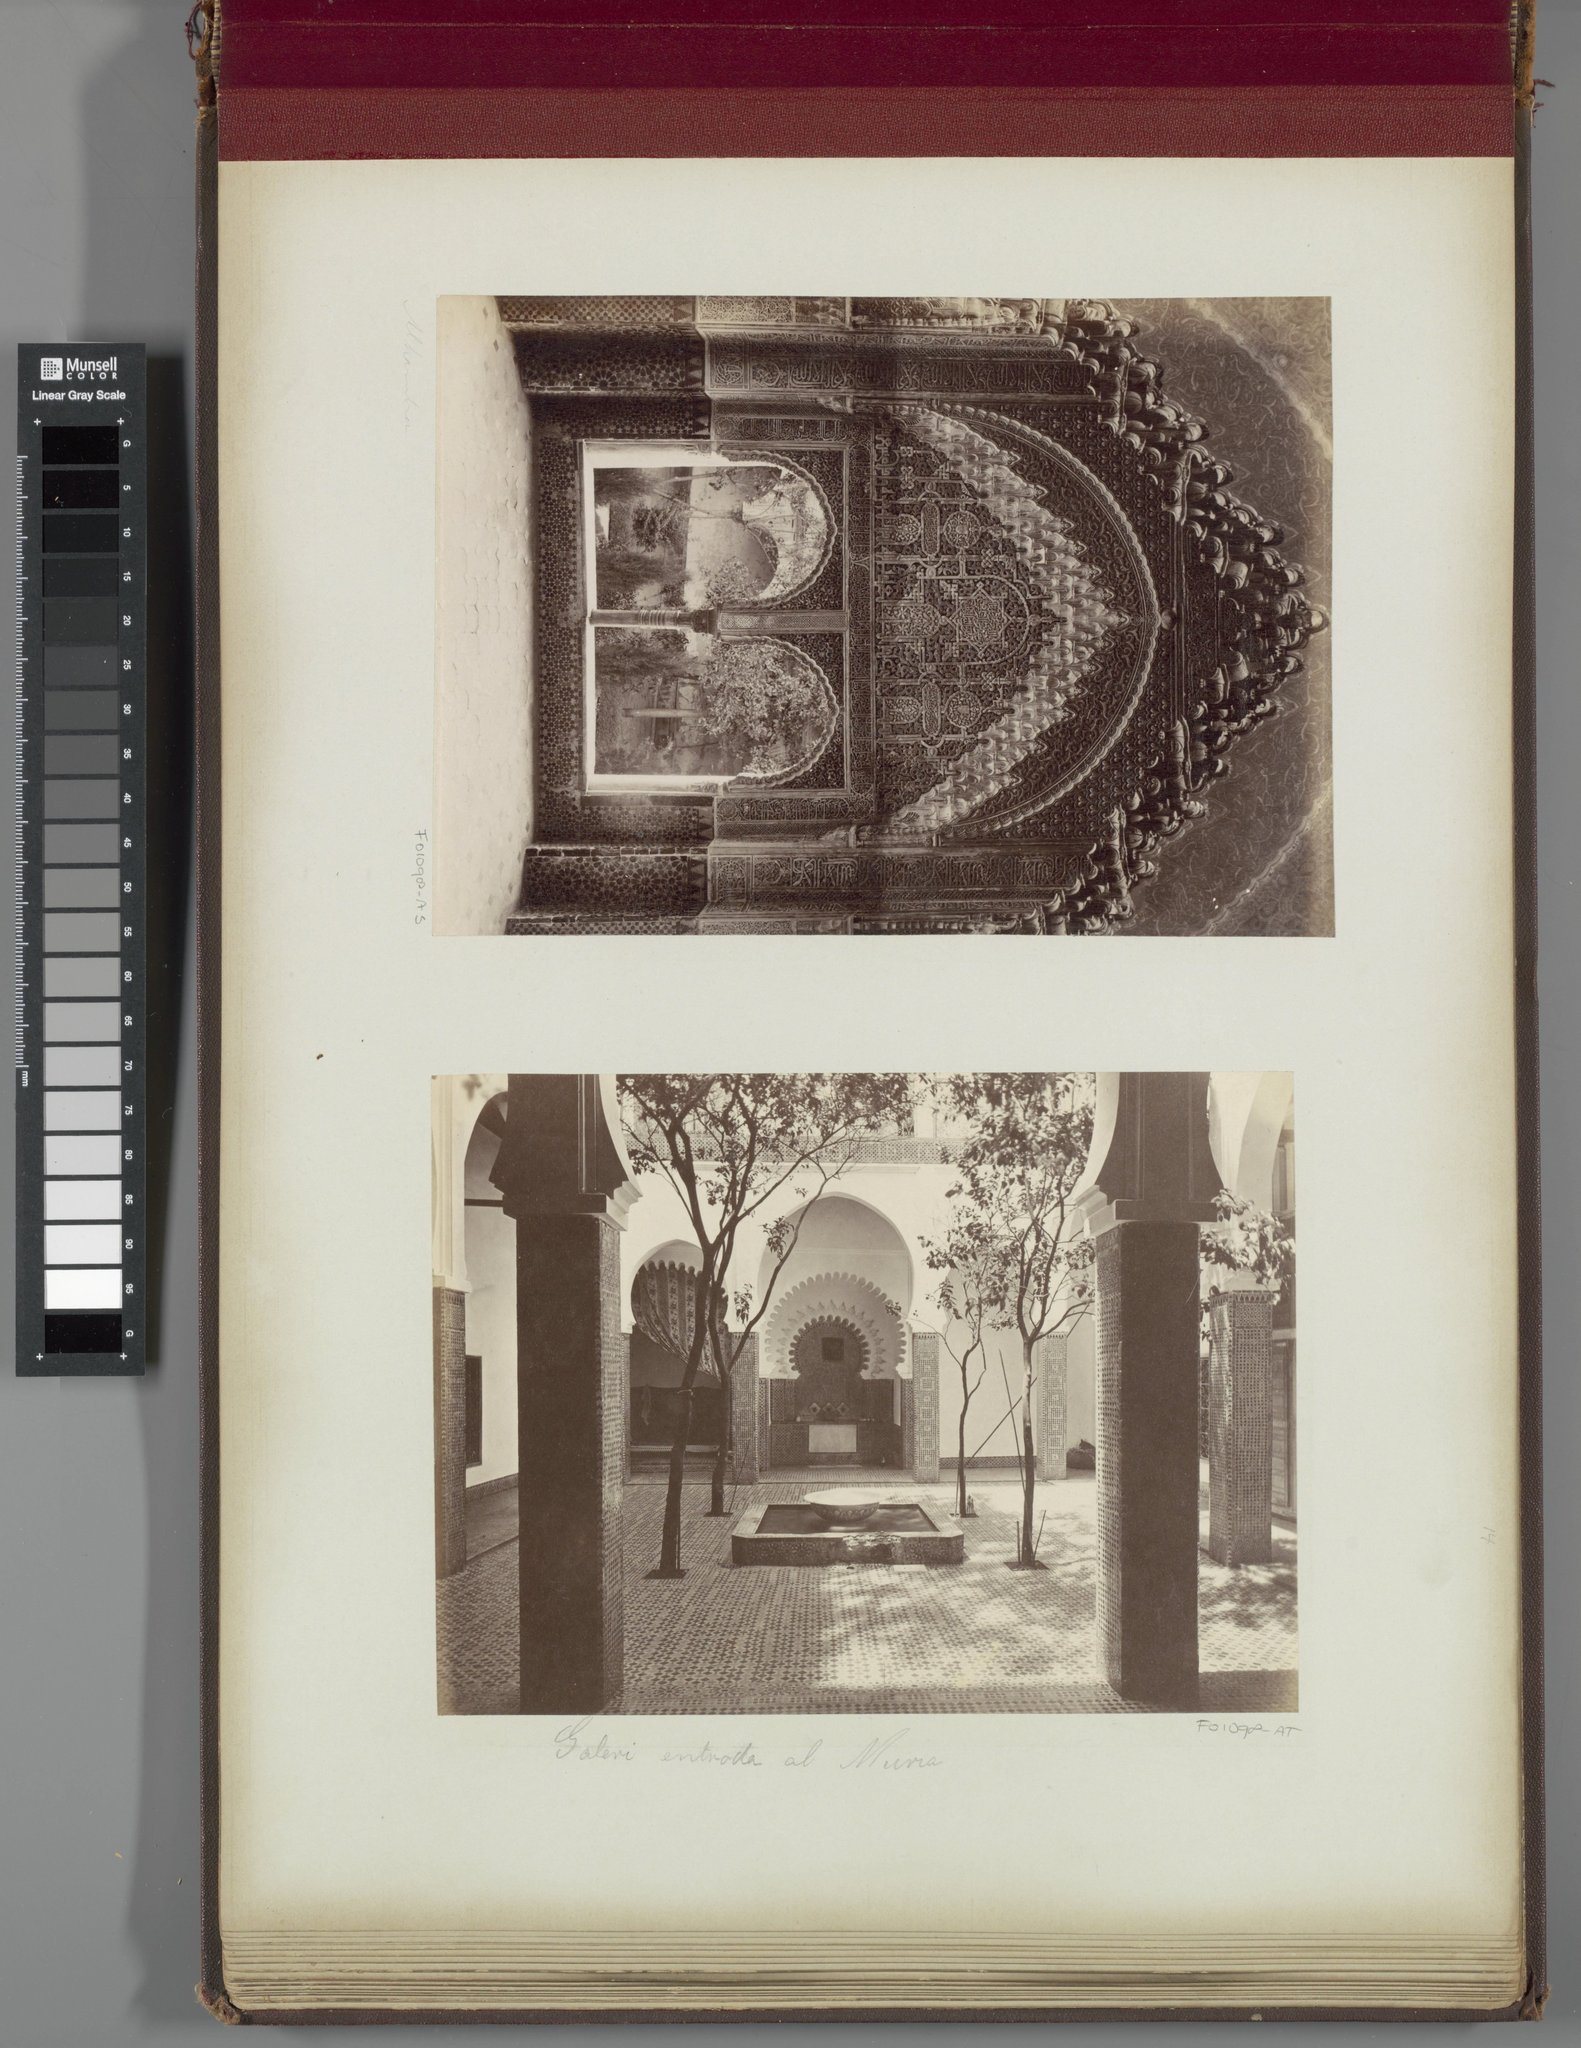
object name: photograph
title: Binnenhof met waterbassin in een Moors gebouw in Spanje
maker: Anonymous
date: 1860-1880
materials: cardboard, paper, photographic support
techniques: albumen print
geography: spain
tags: courtyard, utilitarian, public pump or water fountain, spain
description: Onderdeel van Reisalbum met foto's van bezienswaardigheden in Spanje en Marokko.